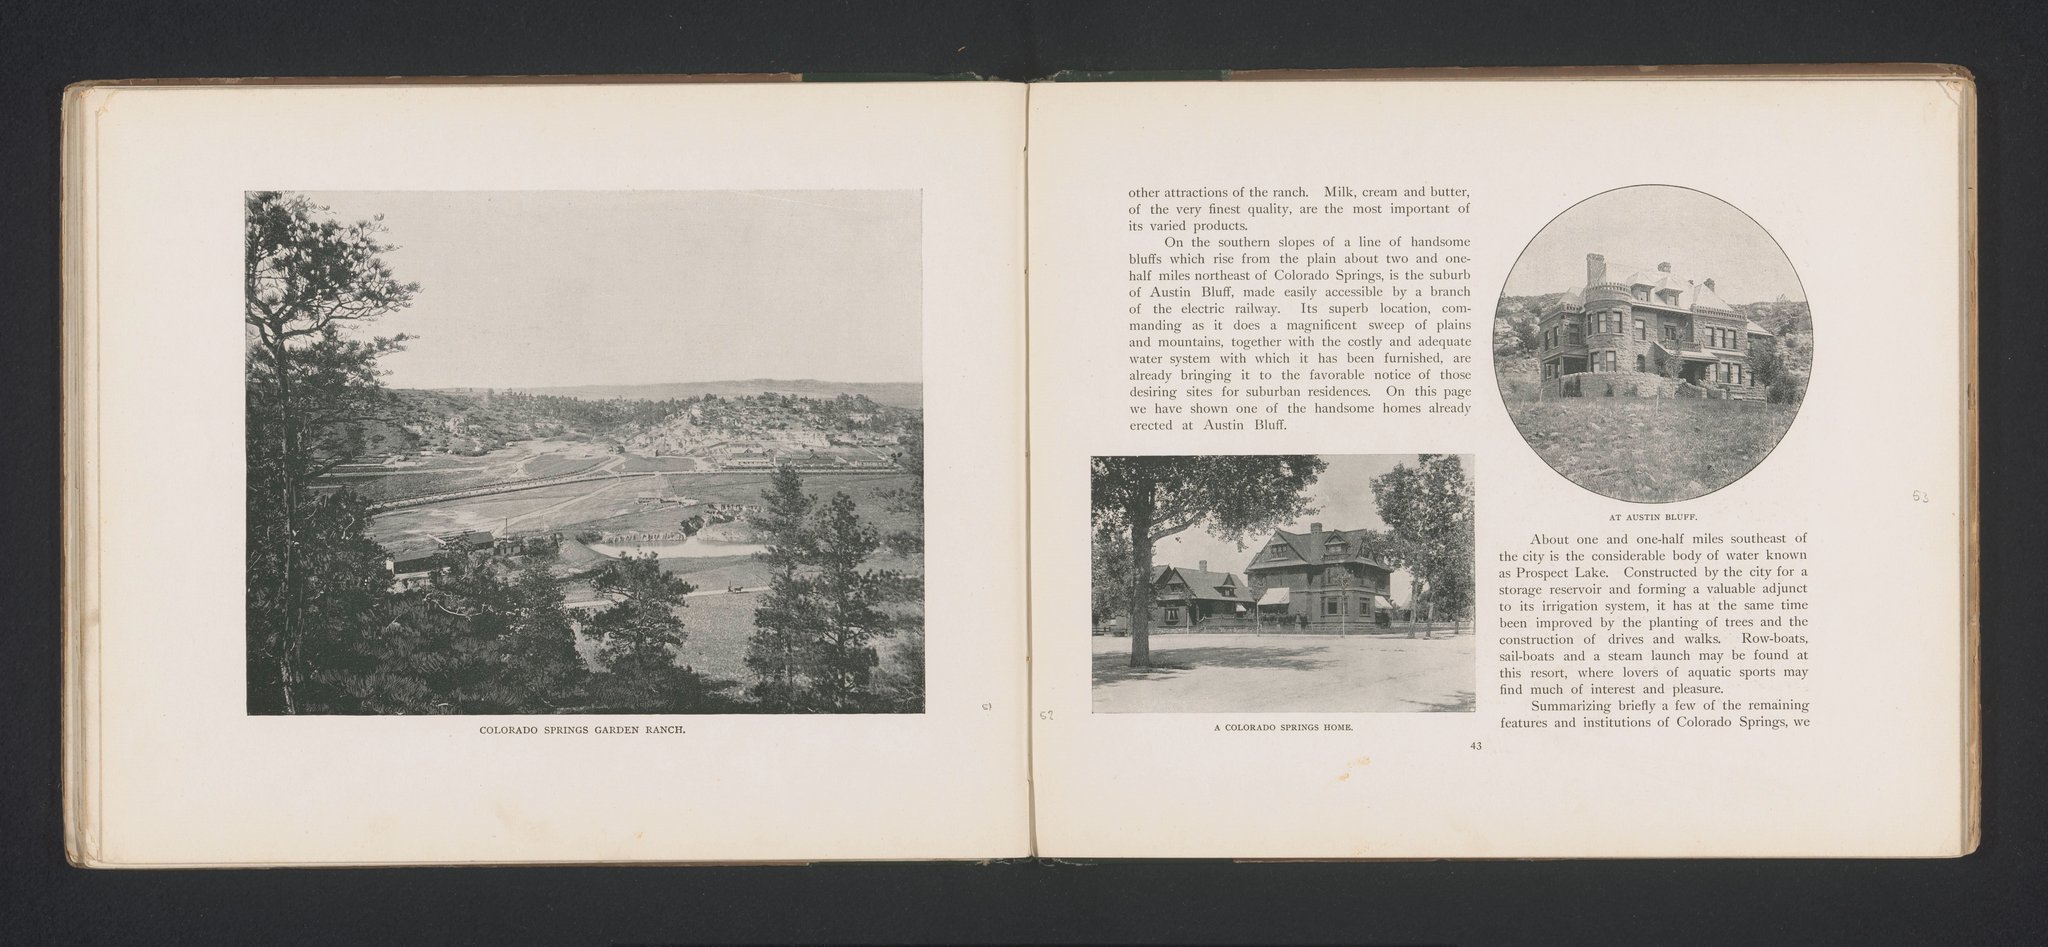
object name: photomechanical print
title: Landschap bij Colorado Springs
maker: Anonymous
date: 1888-1893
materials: paper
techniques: autotype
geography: new york city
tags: landscapes